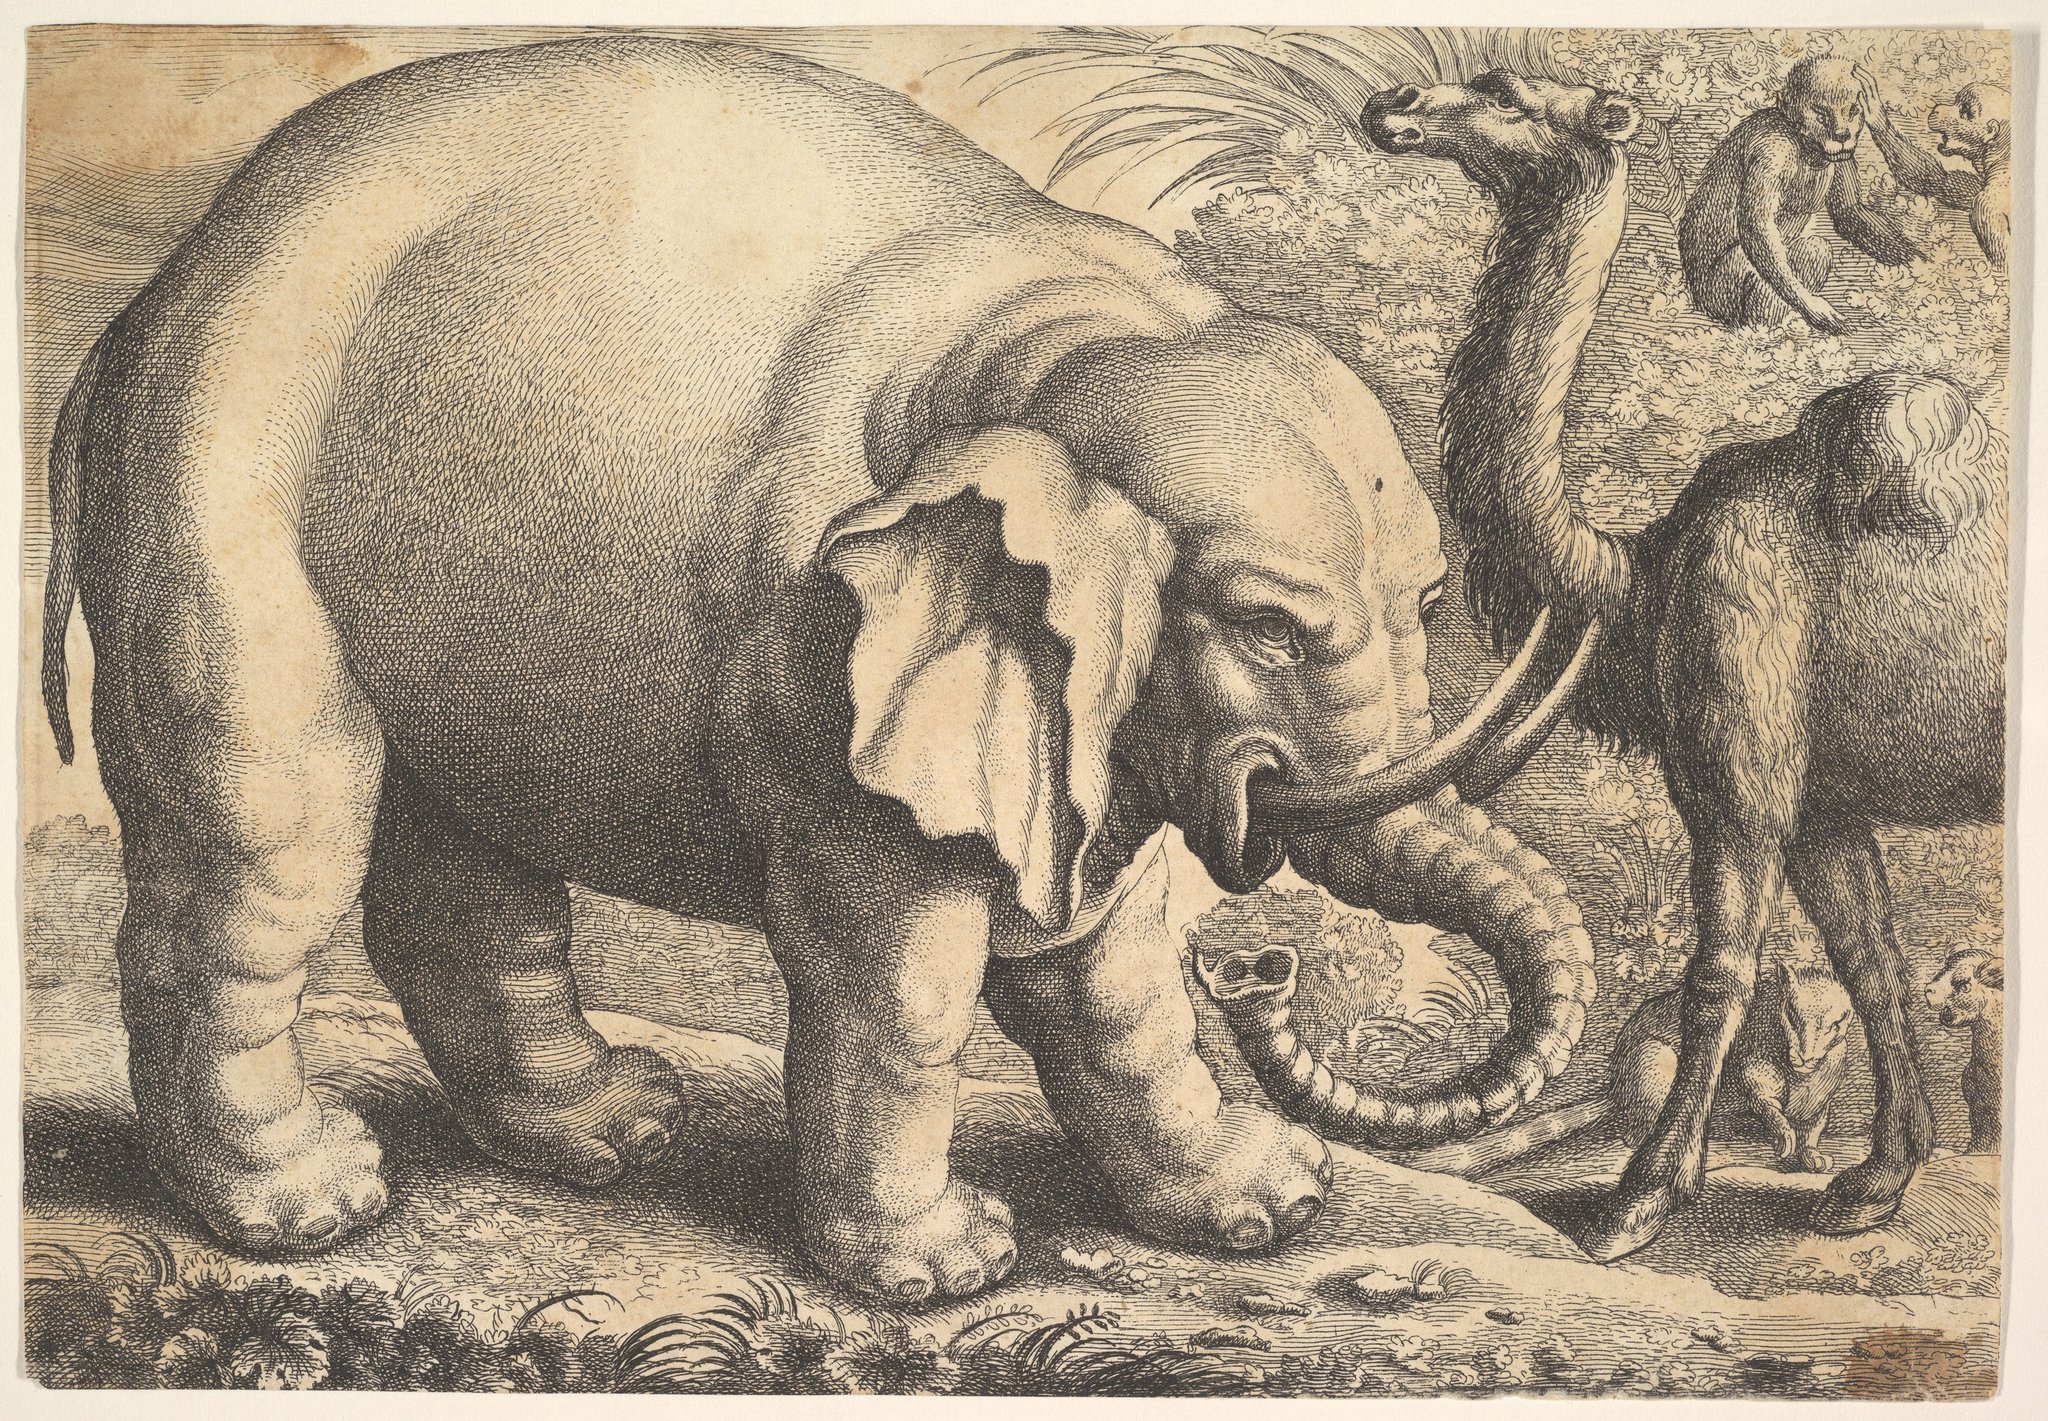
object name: print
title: Elephant and Camel (reverse copy)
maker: wenceslaus hollar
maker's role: artist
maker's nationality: bohemian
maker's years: 1607-1677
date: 1601-1700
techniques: etching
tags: camels,elephants